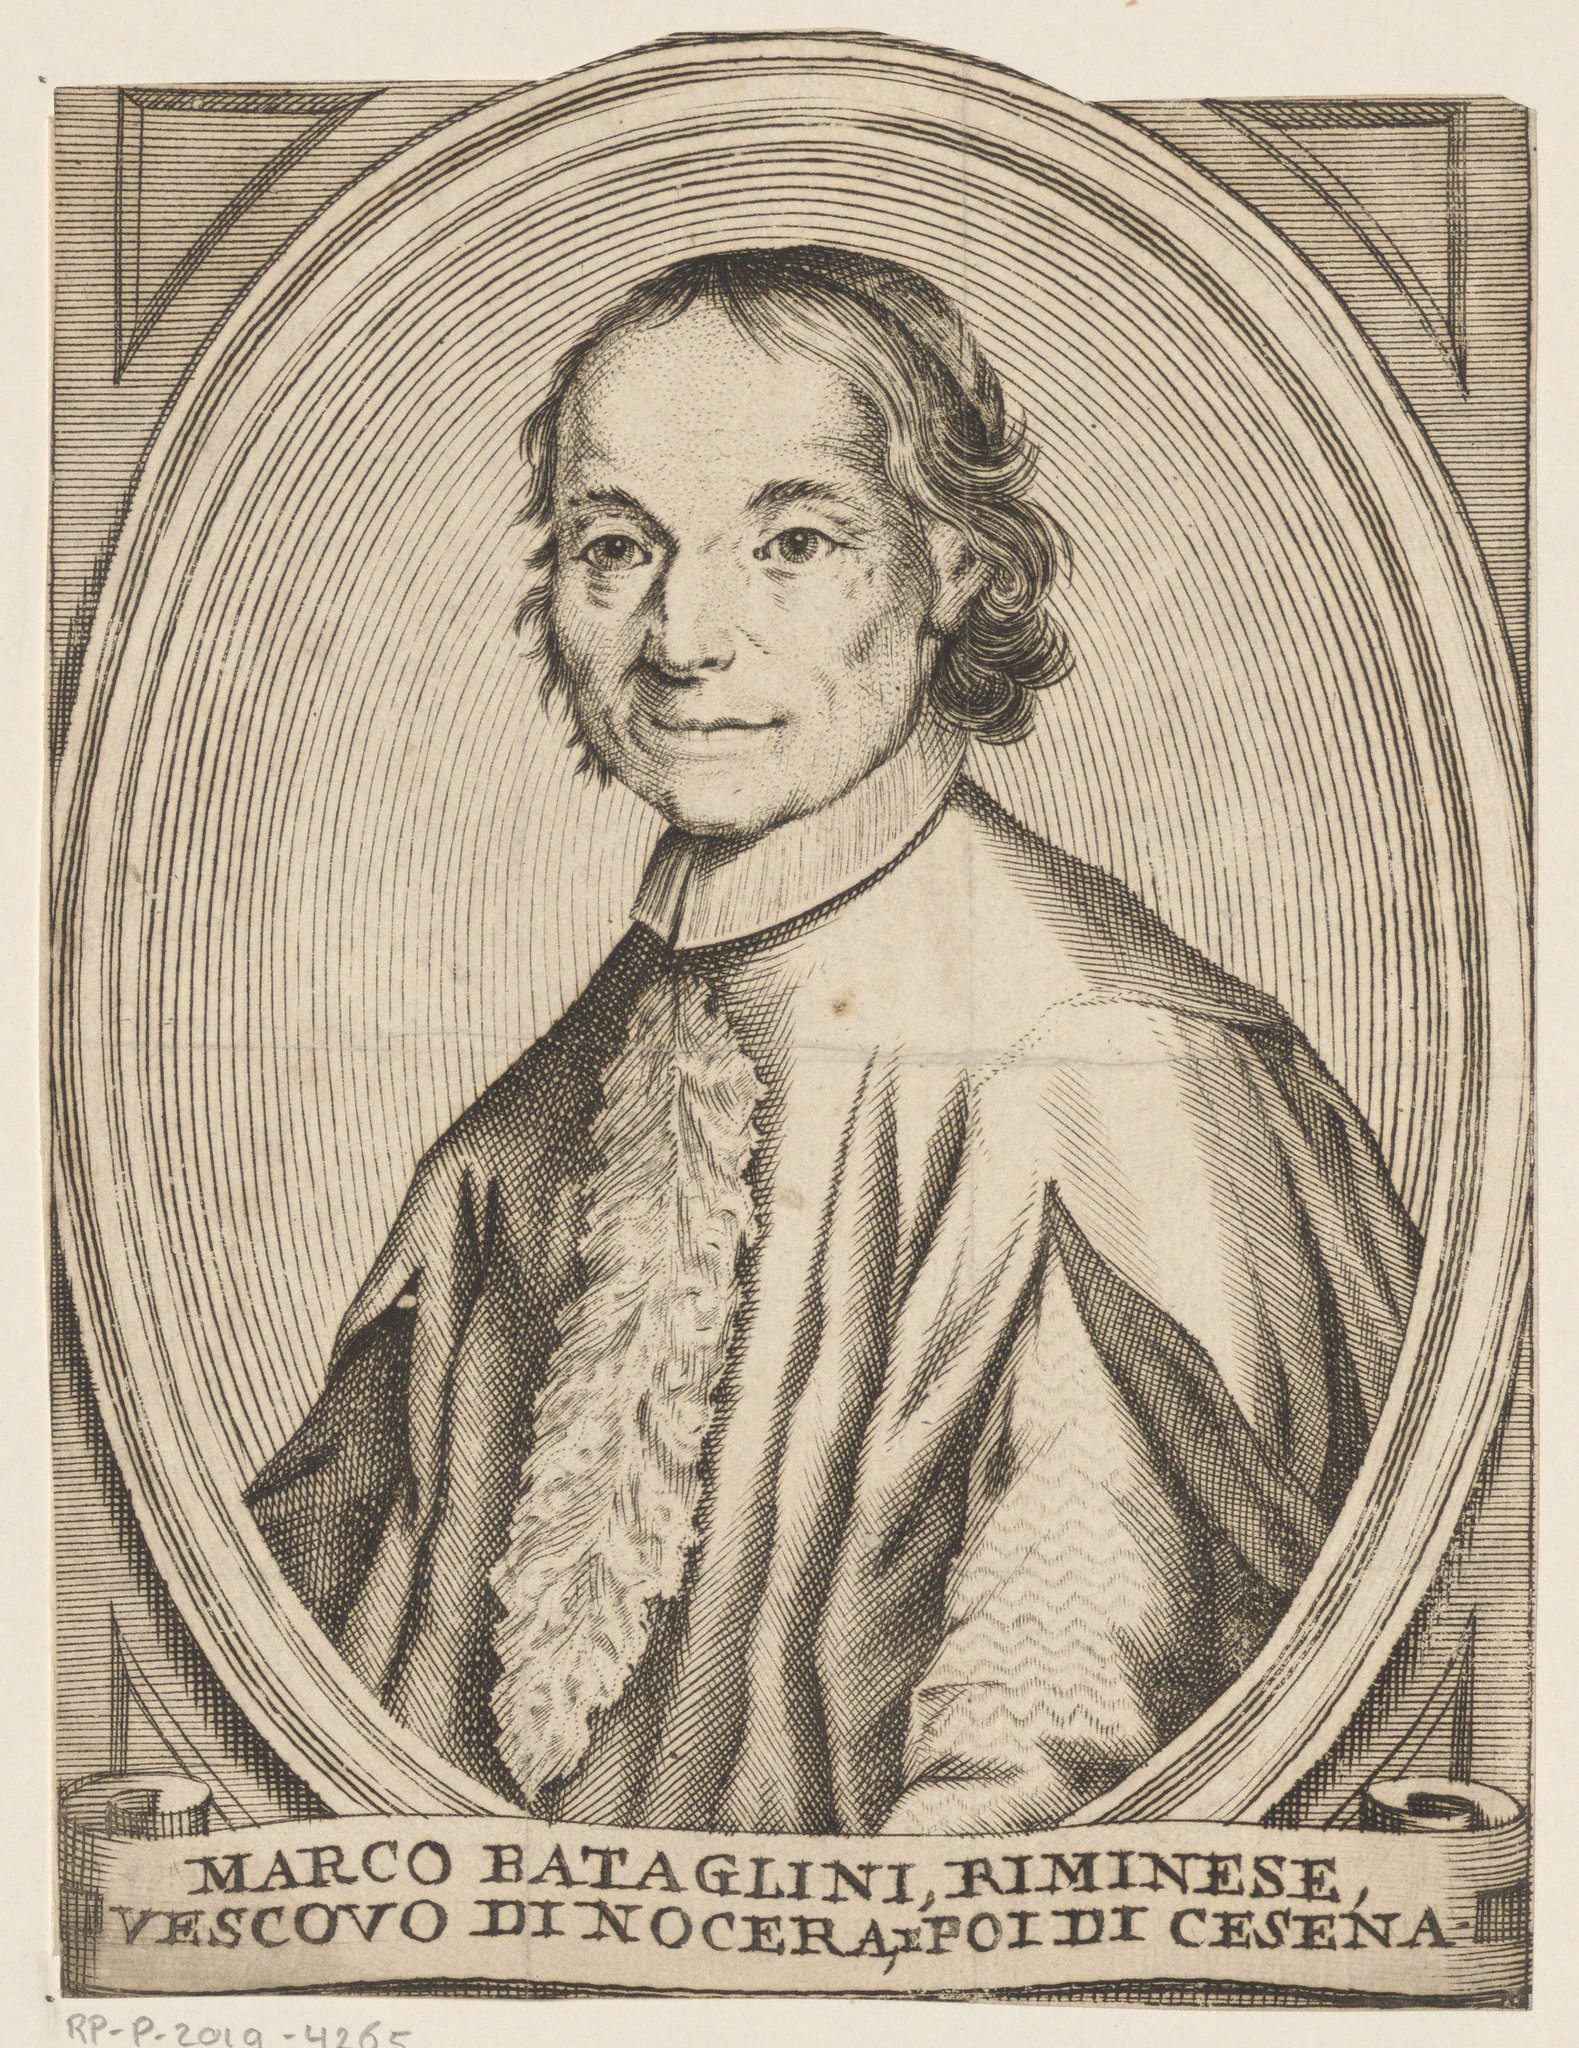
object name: print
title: Portret van Marco Battaglini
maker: Anonymous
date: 1700-1749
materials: paper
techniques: engraving, etching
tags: priest, historical persons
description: Oorspronkelijk links- en rechtsboven genummerd: Tom: XXIV. Tav. V. Pag 288. Hier weggesneden.